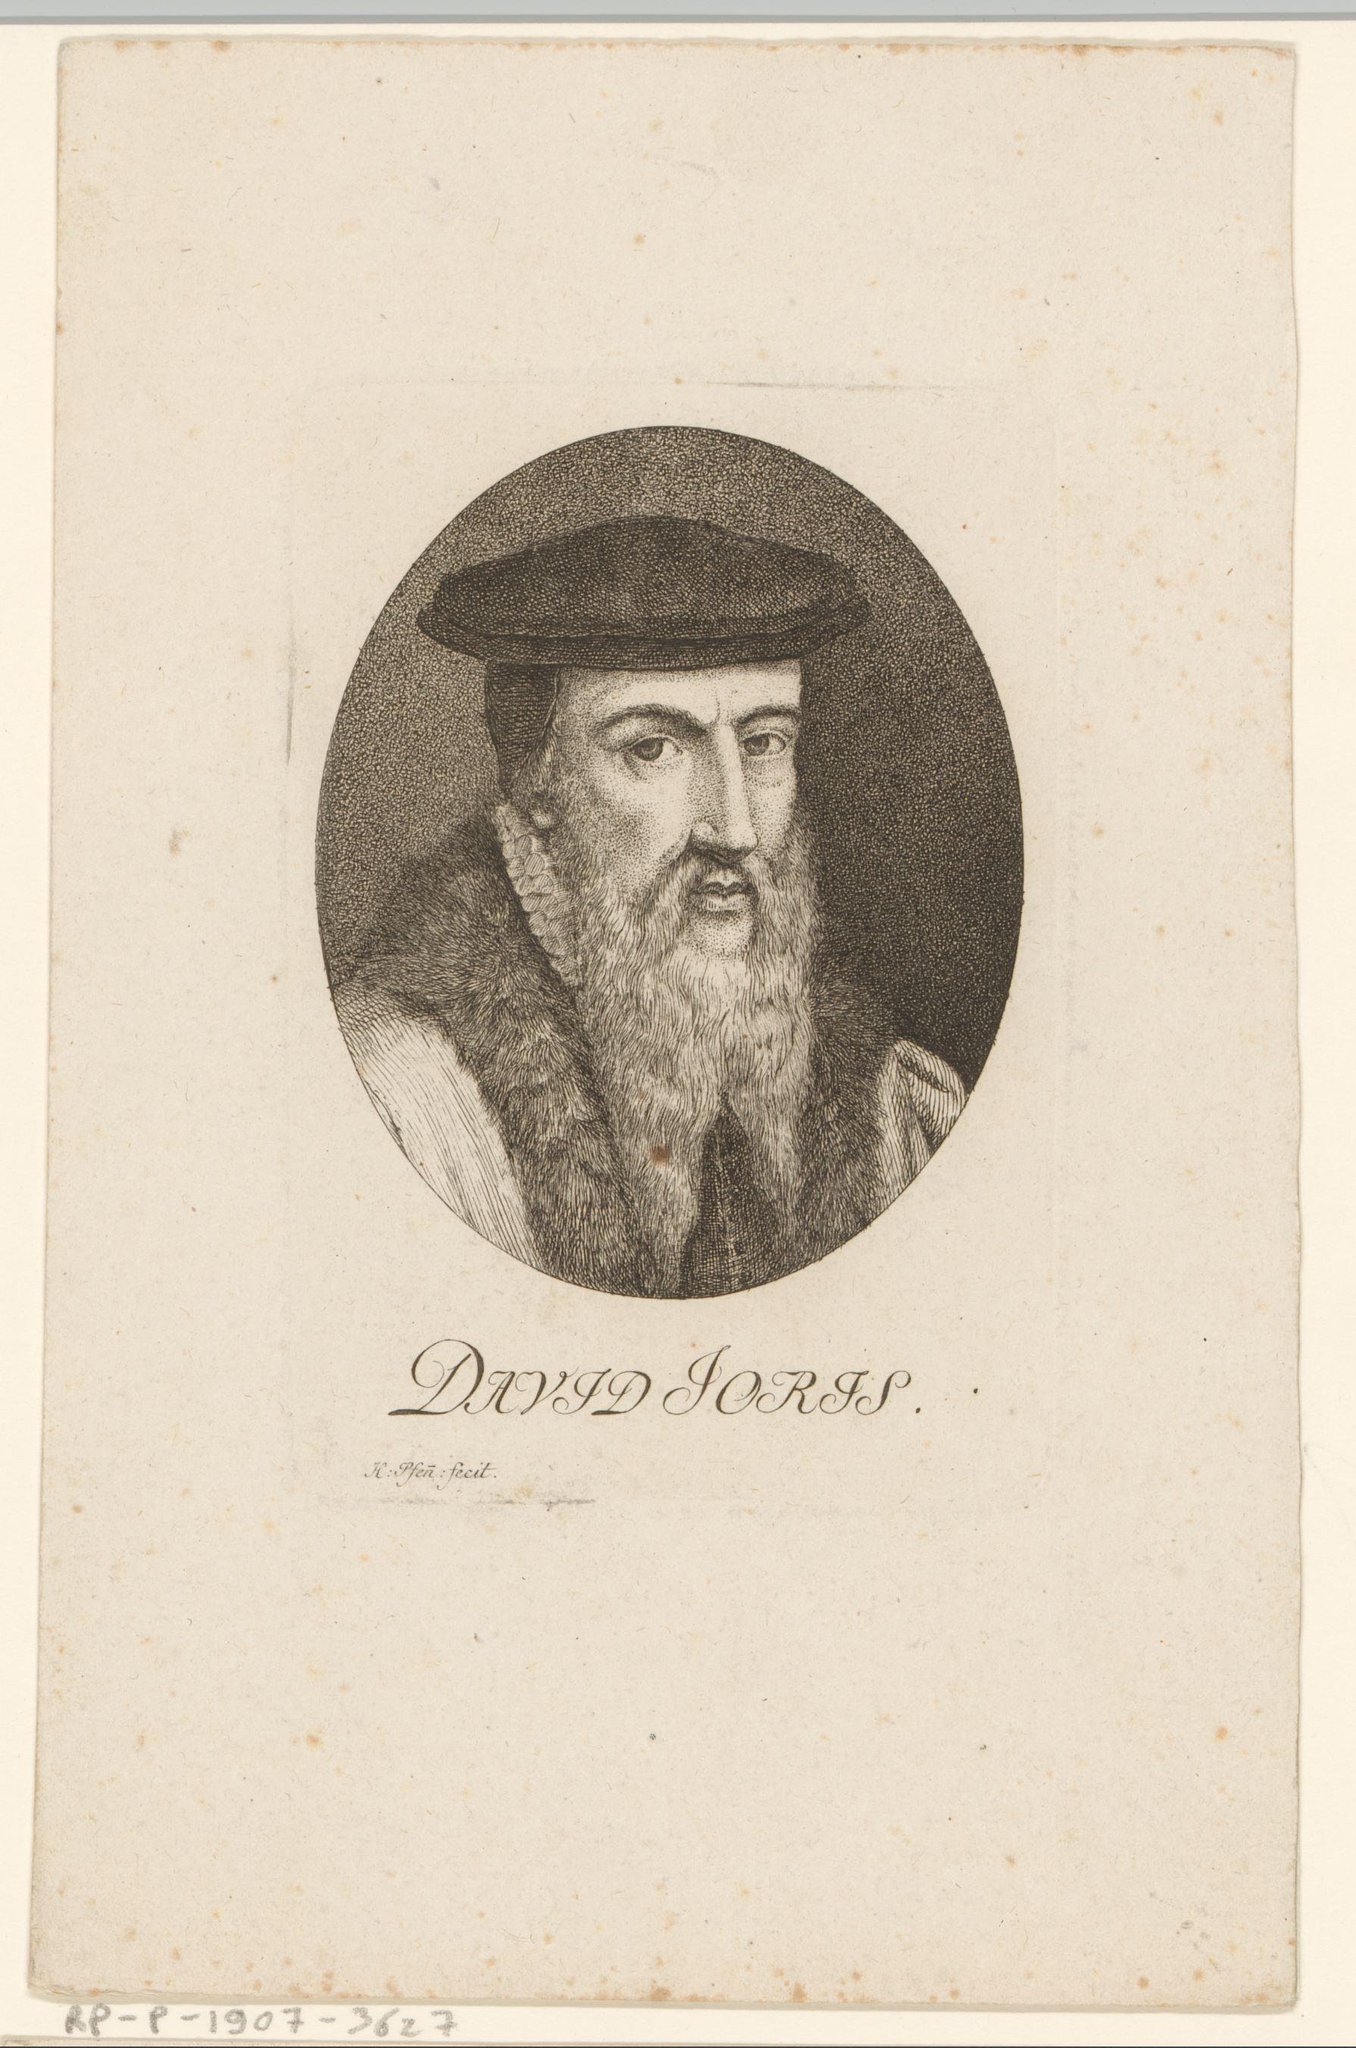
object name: print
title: Portret van David Jorisz.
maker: heinrich pfenninger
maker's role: print maker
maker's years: 1749-1815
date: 1759-1815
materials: paper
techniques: etching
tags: bruges, david jorisz., historical persons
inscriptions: collector's mark: Lugt 2228